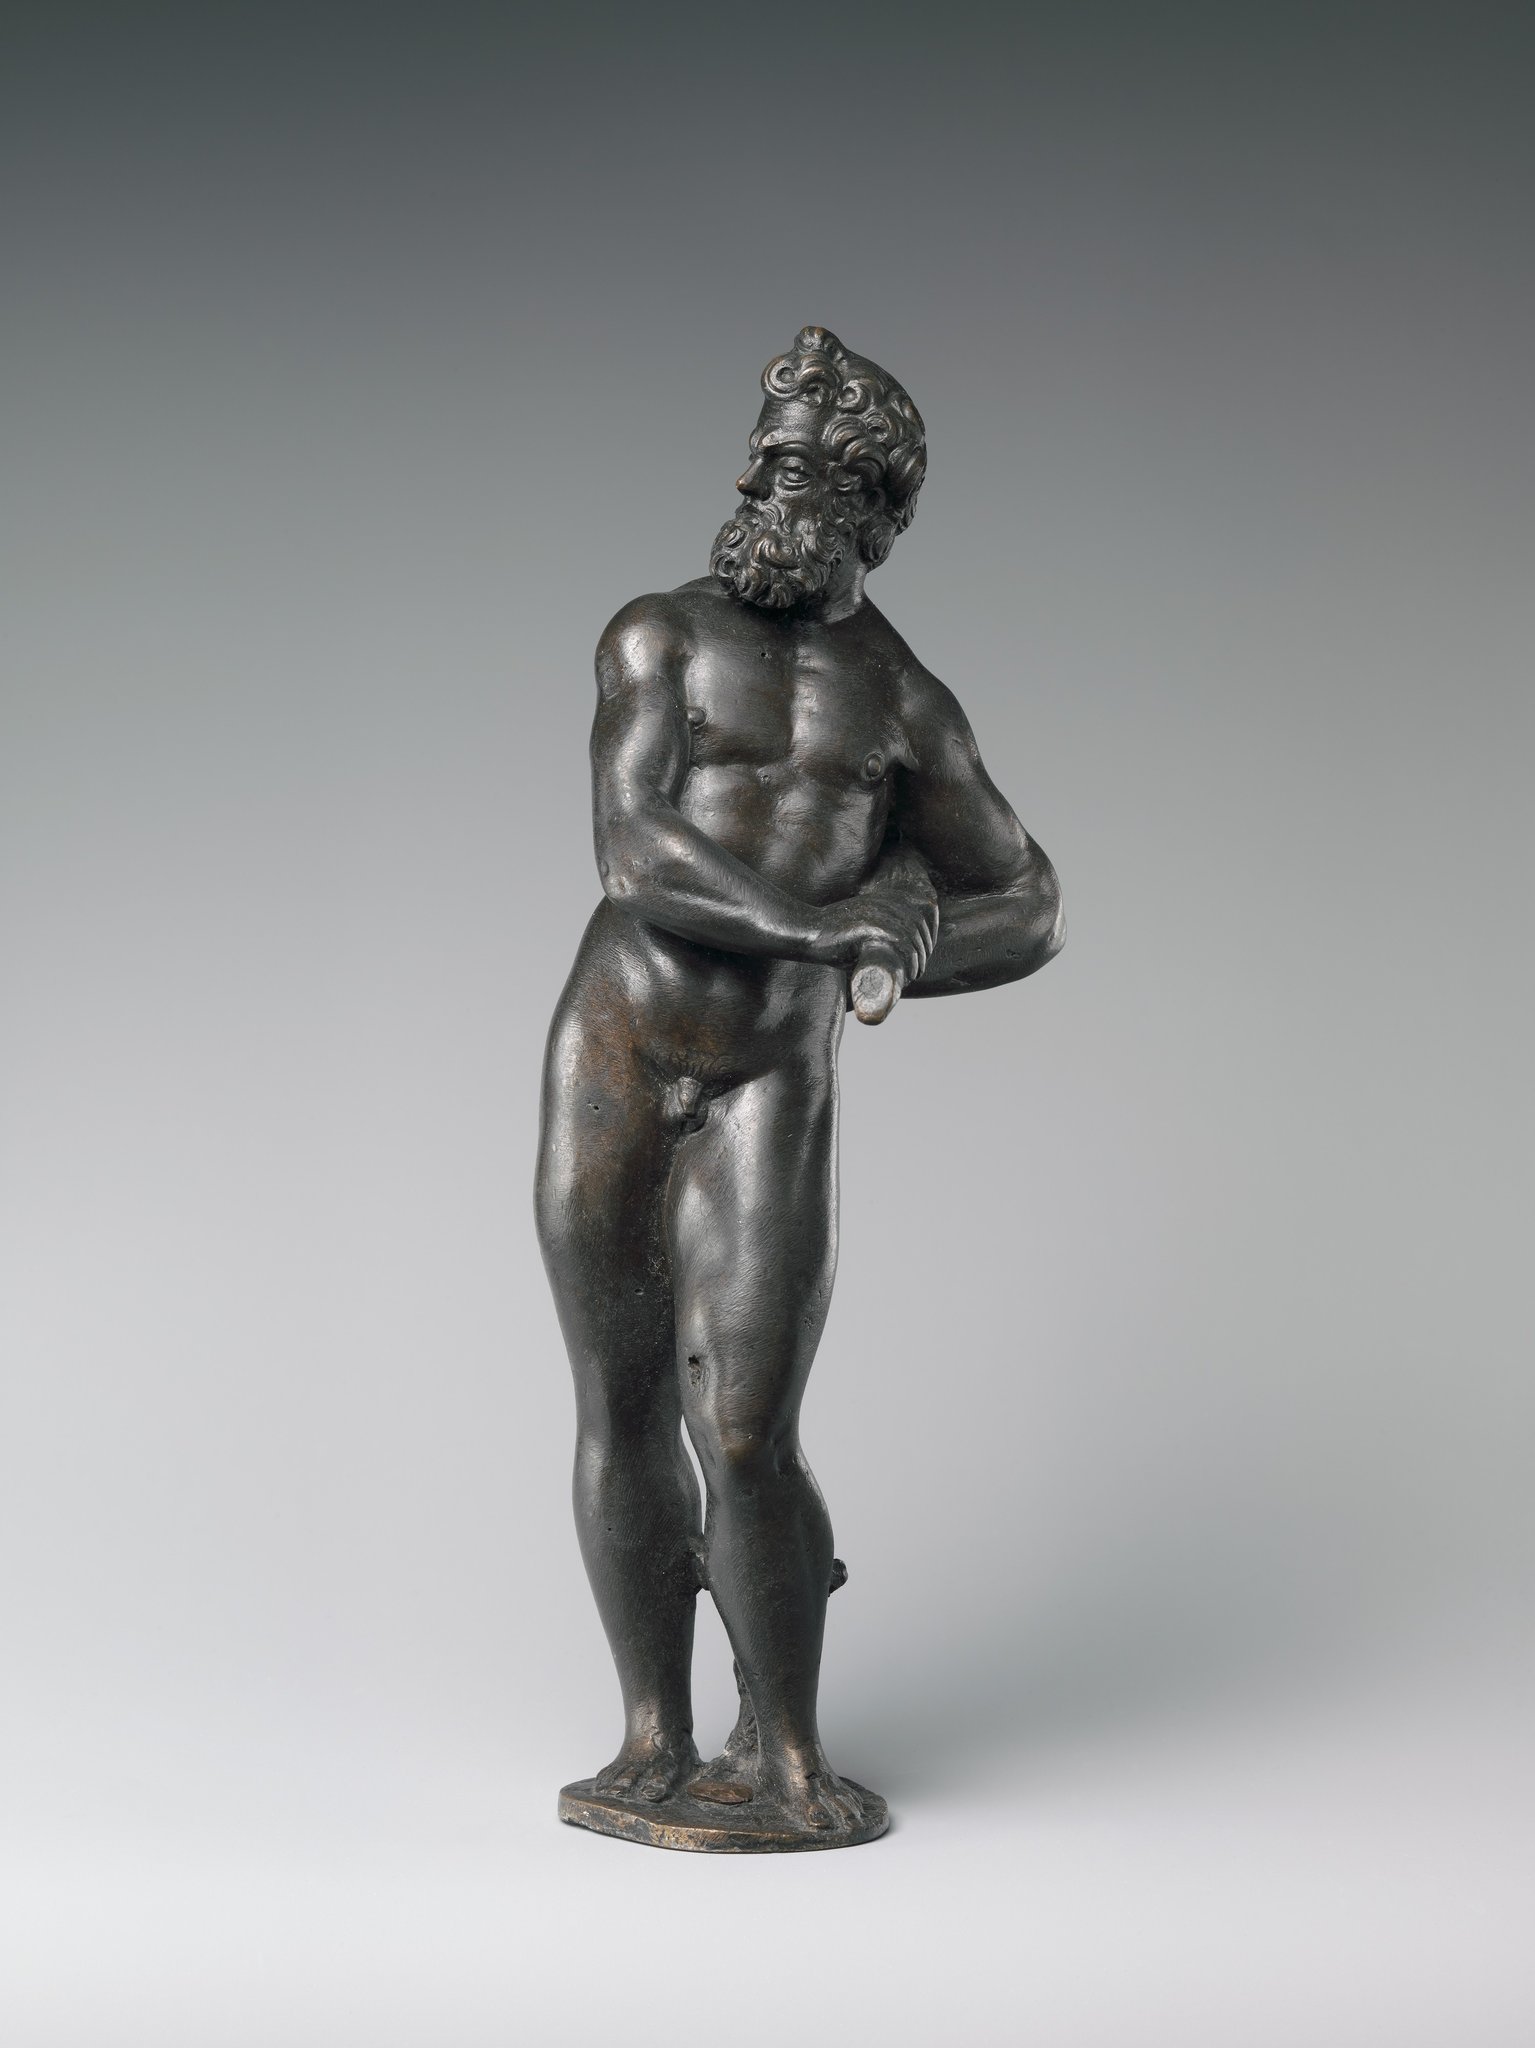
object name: statuette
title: Hercules carrying his club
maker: niccolò roccatagliata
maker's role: artist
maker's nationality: italian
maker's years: 1593-1636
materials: bronze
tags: hercules